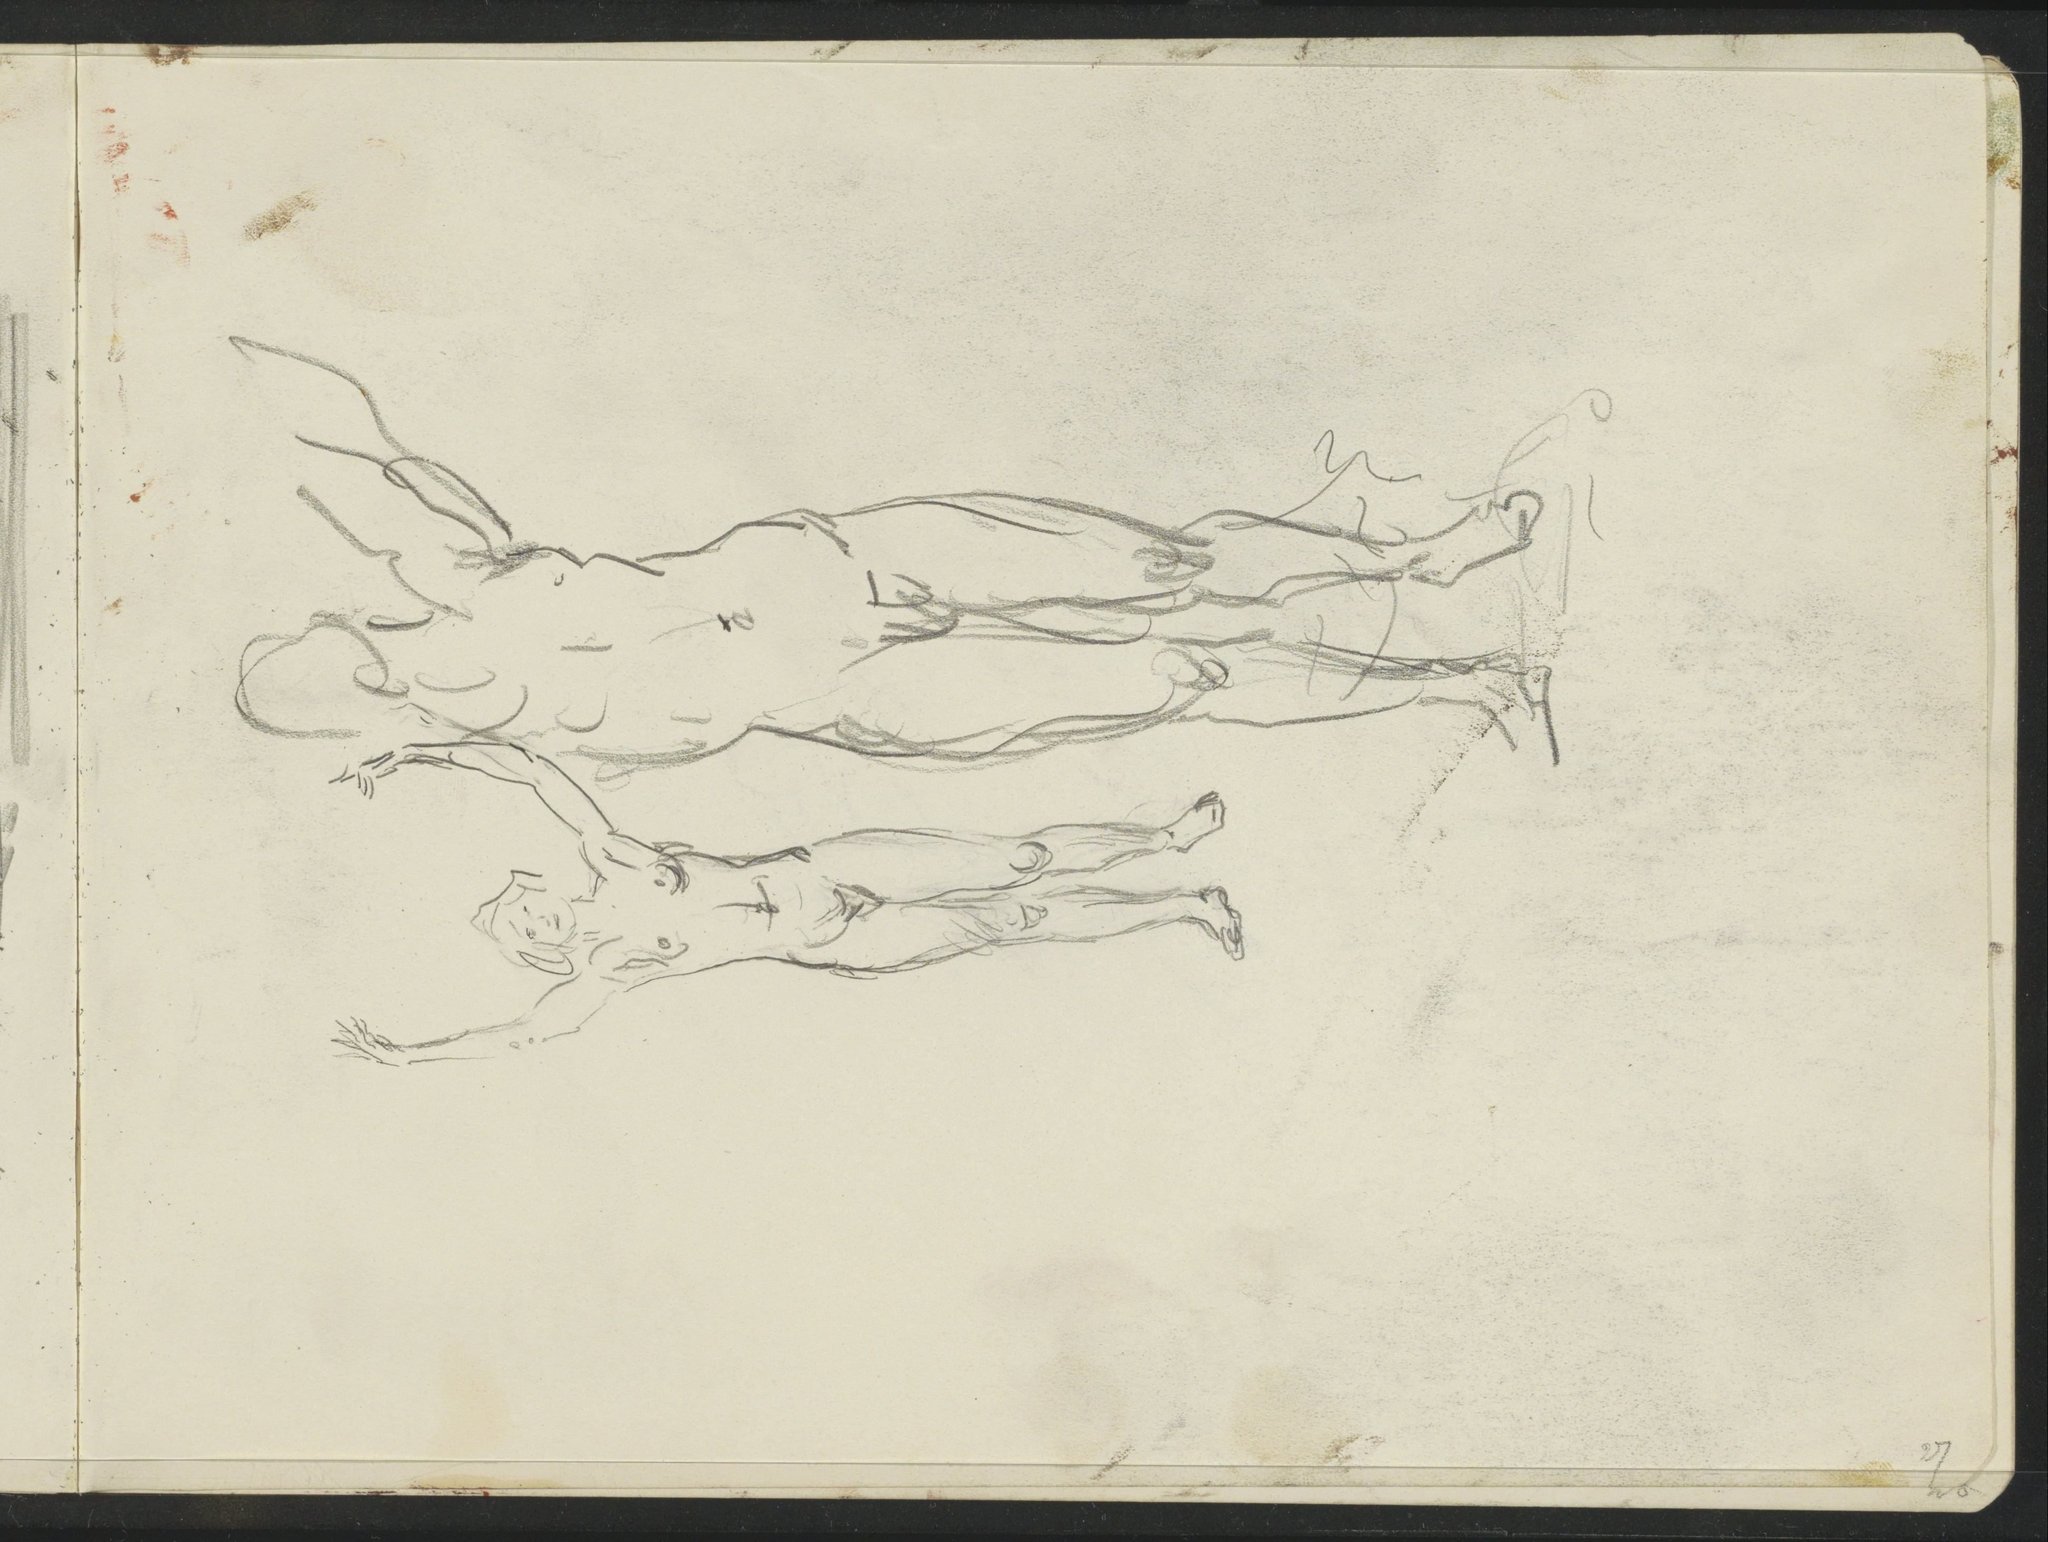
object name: sketchbook leaf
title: Twee vrouwelijke naakten, staand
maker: isaac israels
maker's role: draughtsman, painter, print maker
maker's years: 1865-1934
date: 1915-1934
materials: paper, pencil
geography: the hague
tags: the (nude) human figure; 'corpo humano' (ripa) - aa - female human figure (+ standing), arm raised upward - aa - both arms or hands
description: Met hun armen in de lucht. Blad 27 recto uit schetsboek XVIII met 35 bladen.